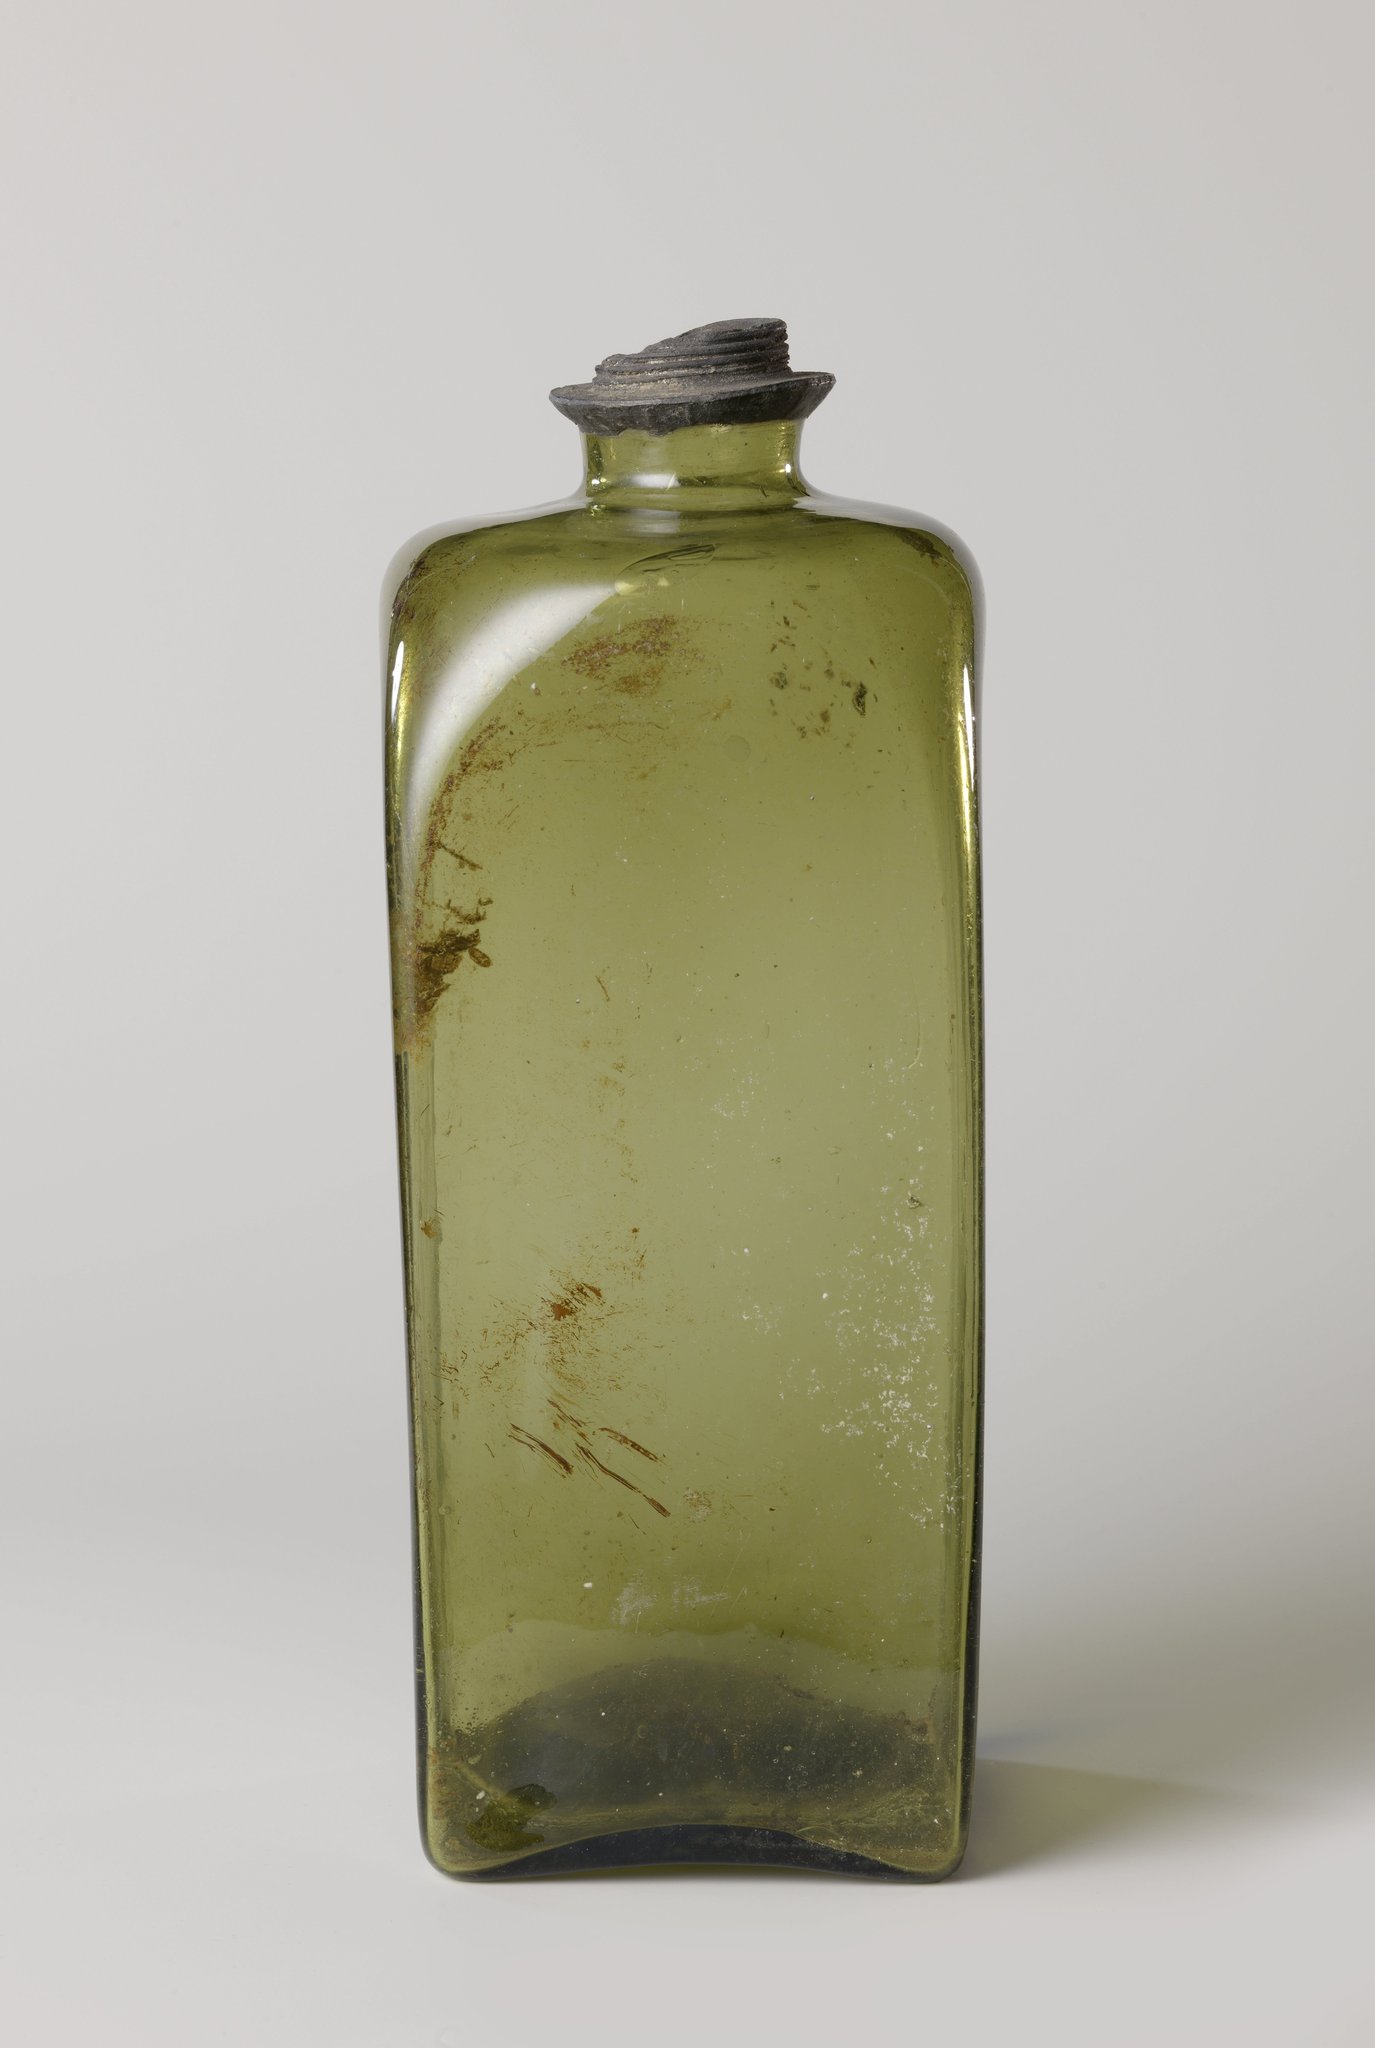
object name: bottle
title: Vierkantige fles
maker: Anonymous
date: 1650-1700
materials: glass, tin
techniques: glassblowing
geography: northwest europe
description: Ingestoken ziel, vierkantig lichaam met afgeronde schouder, korte hals met tinnen montering met schroefdraad.